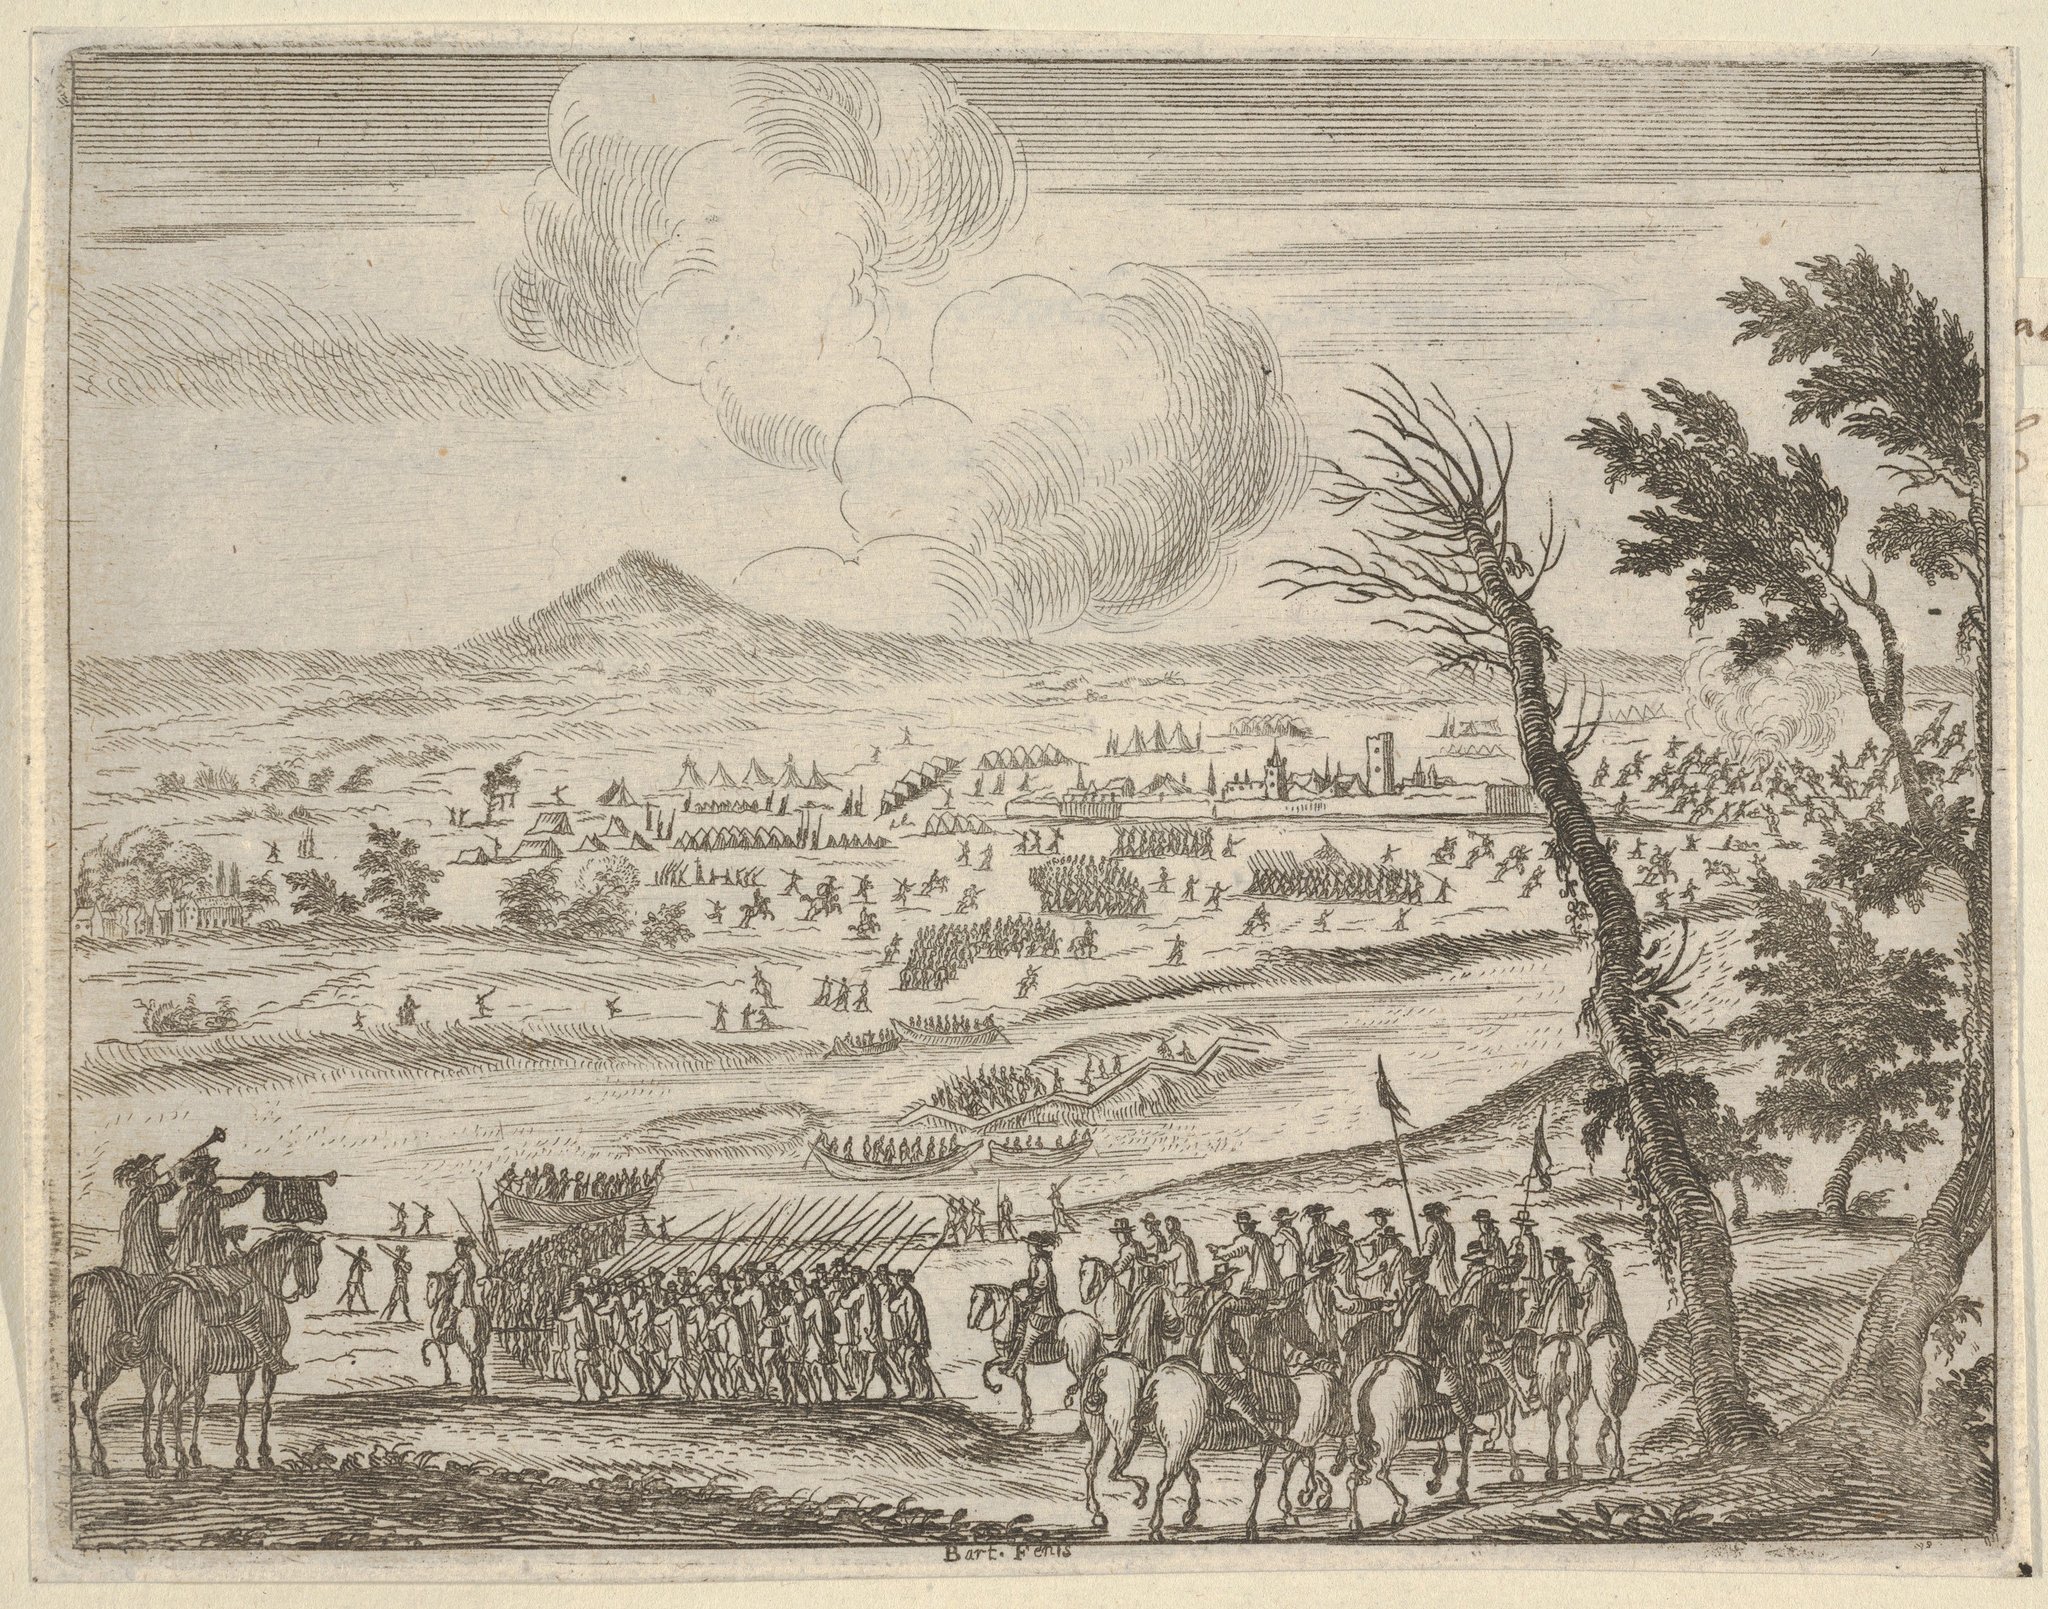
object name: print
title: Francesco I d'Este Protects the French in Casalmaggiore from the Seige of the Spanish, from "L'Idea di un Principe ed Eroe Cristiano in Francesco I d'Este, di Modena e Reggio Duca VIII [...]"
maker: bartolomeo fenice (fénis)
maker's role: artist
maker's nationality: italian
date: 1659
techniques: etching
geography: italy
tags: battles,soldiers,men,horses